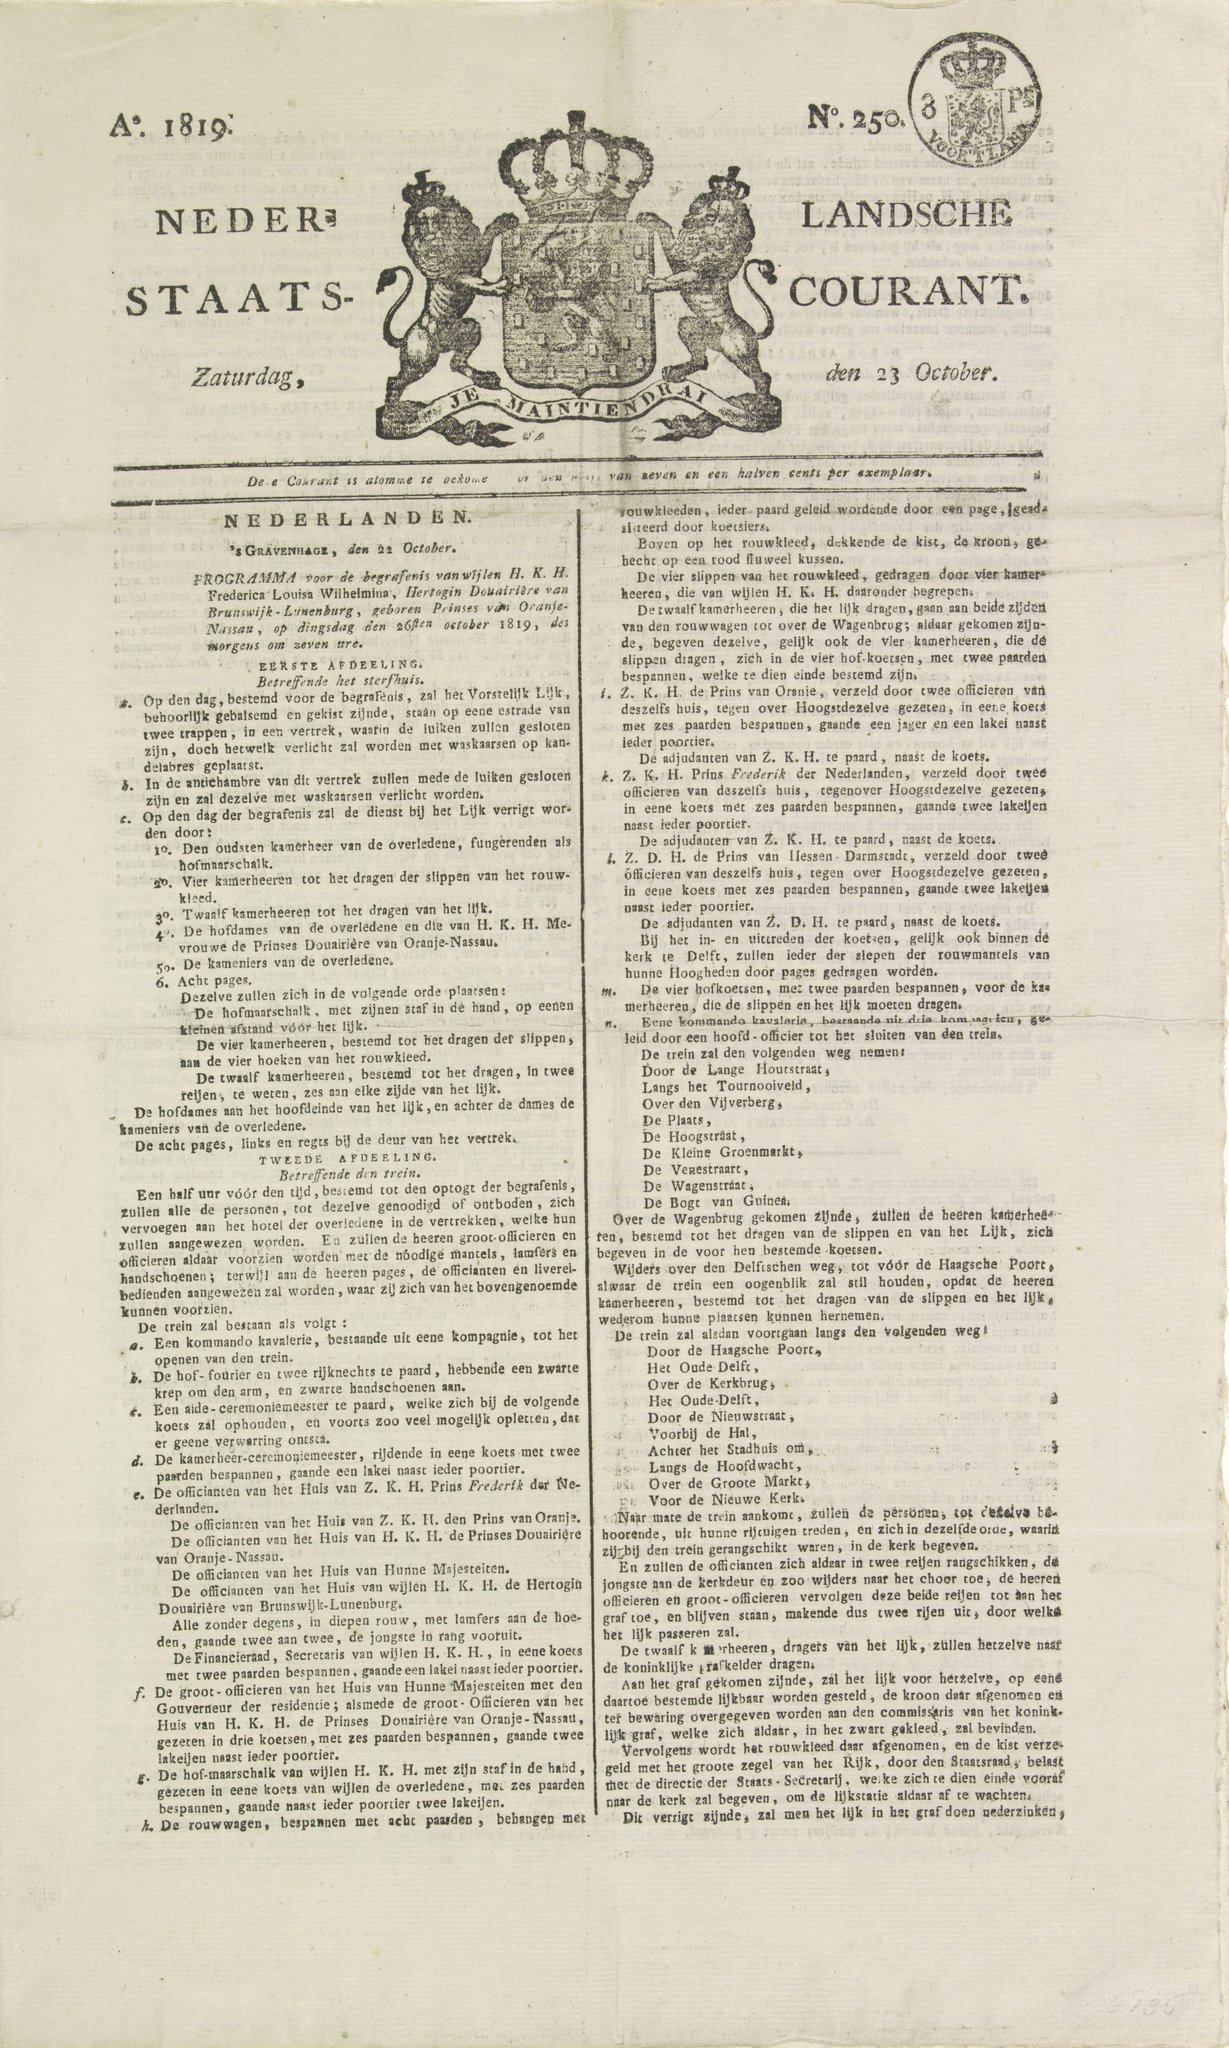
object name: text sheet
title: Nederlandsche Staats-Courant. Zaturdag, den 23 October. Ao. 1819. No. 250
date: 1819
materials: paper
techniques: letterpress printing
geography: the hague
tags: amsterdam, louise (prinses van oranje-nassau), the hague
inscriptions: collector's mark: Lugt 2228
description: Aflevering van de Staatscourant van 23 oktober 1819 met het programma van de begrafenisceremonie te Den Haag van Frederica Louisa Wilhelmina, prinses van Oranje-Nassau, weduwe van hertog Karl George August van Brunswijk, overleden op 15 oktober 1819. Dubbelgevouwen blad met bovenaan het wapen van Nederland.